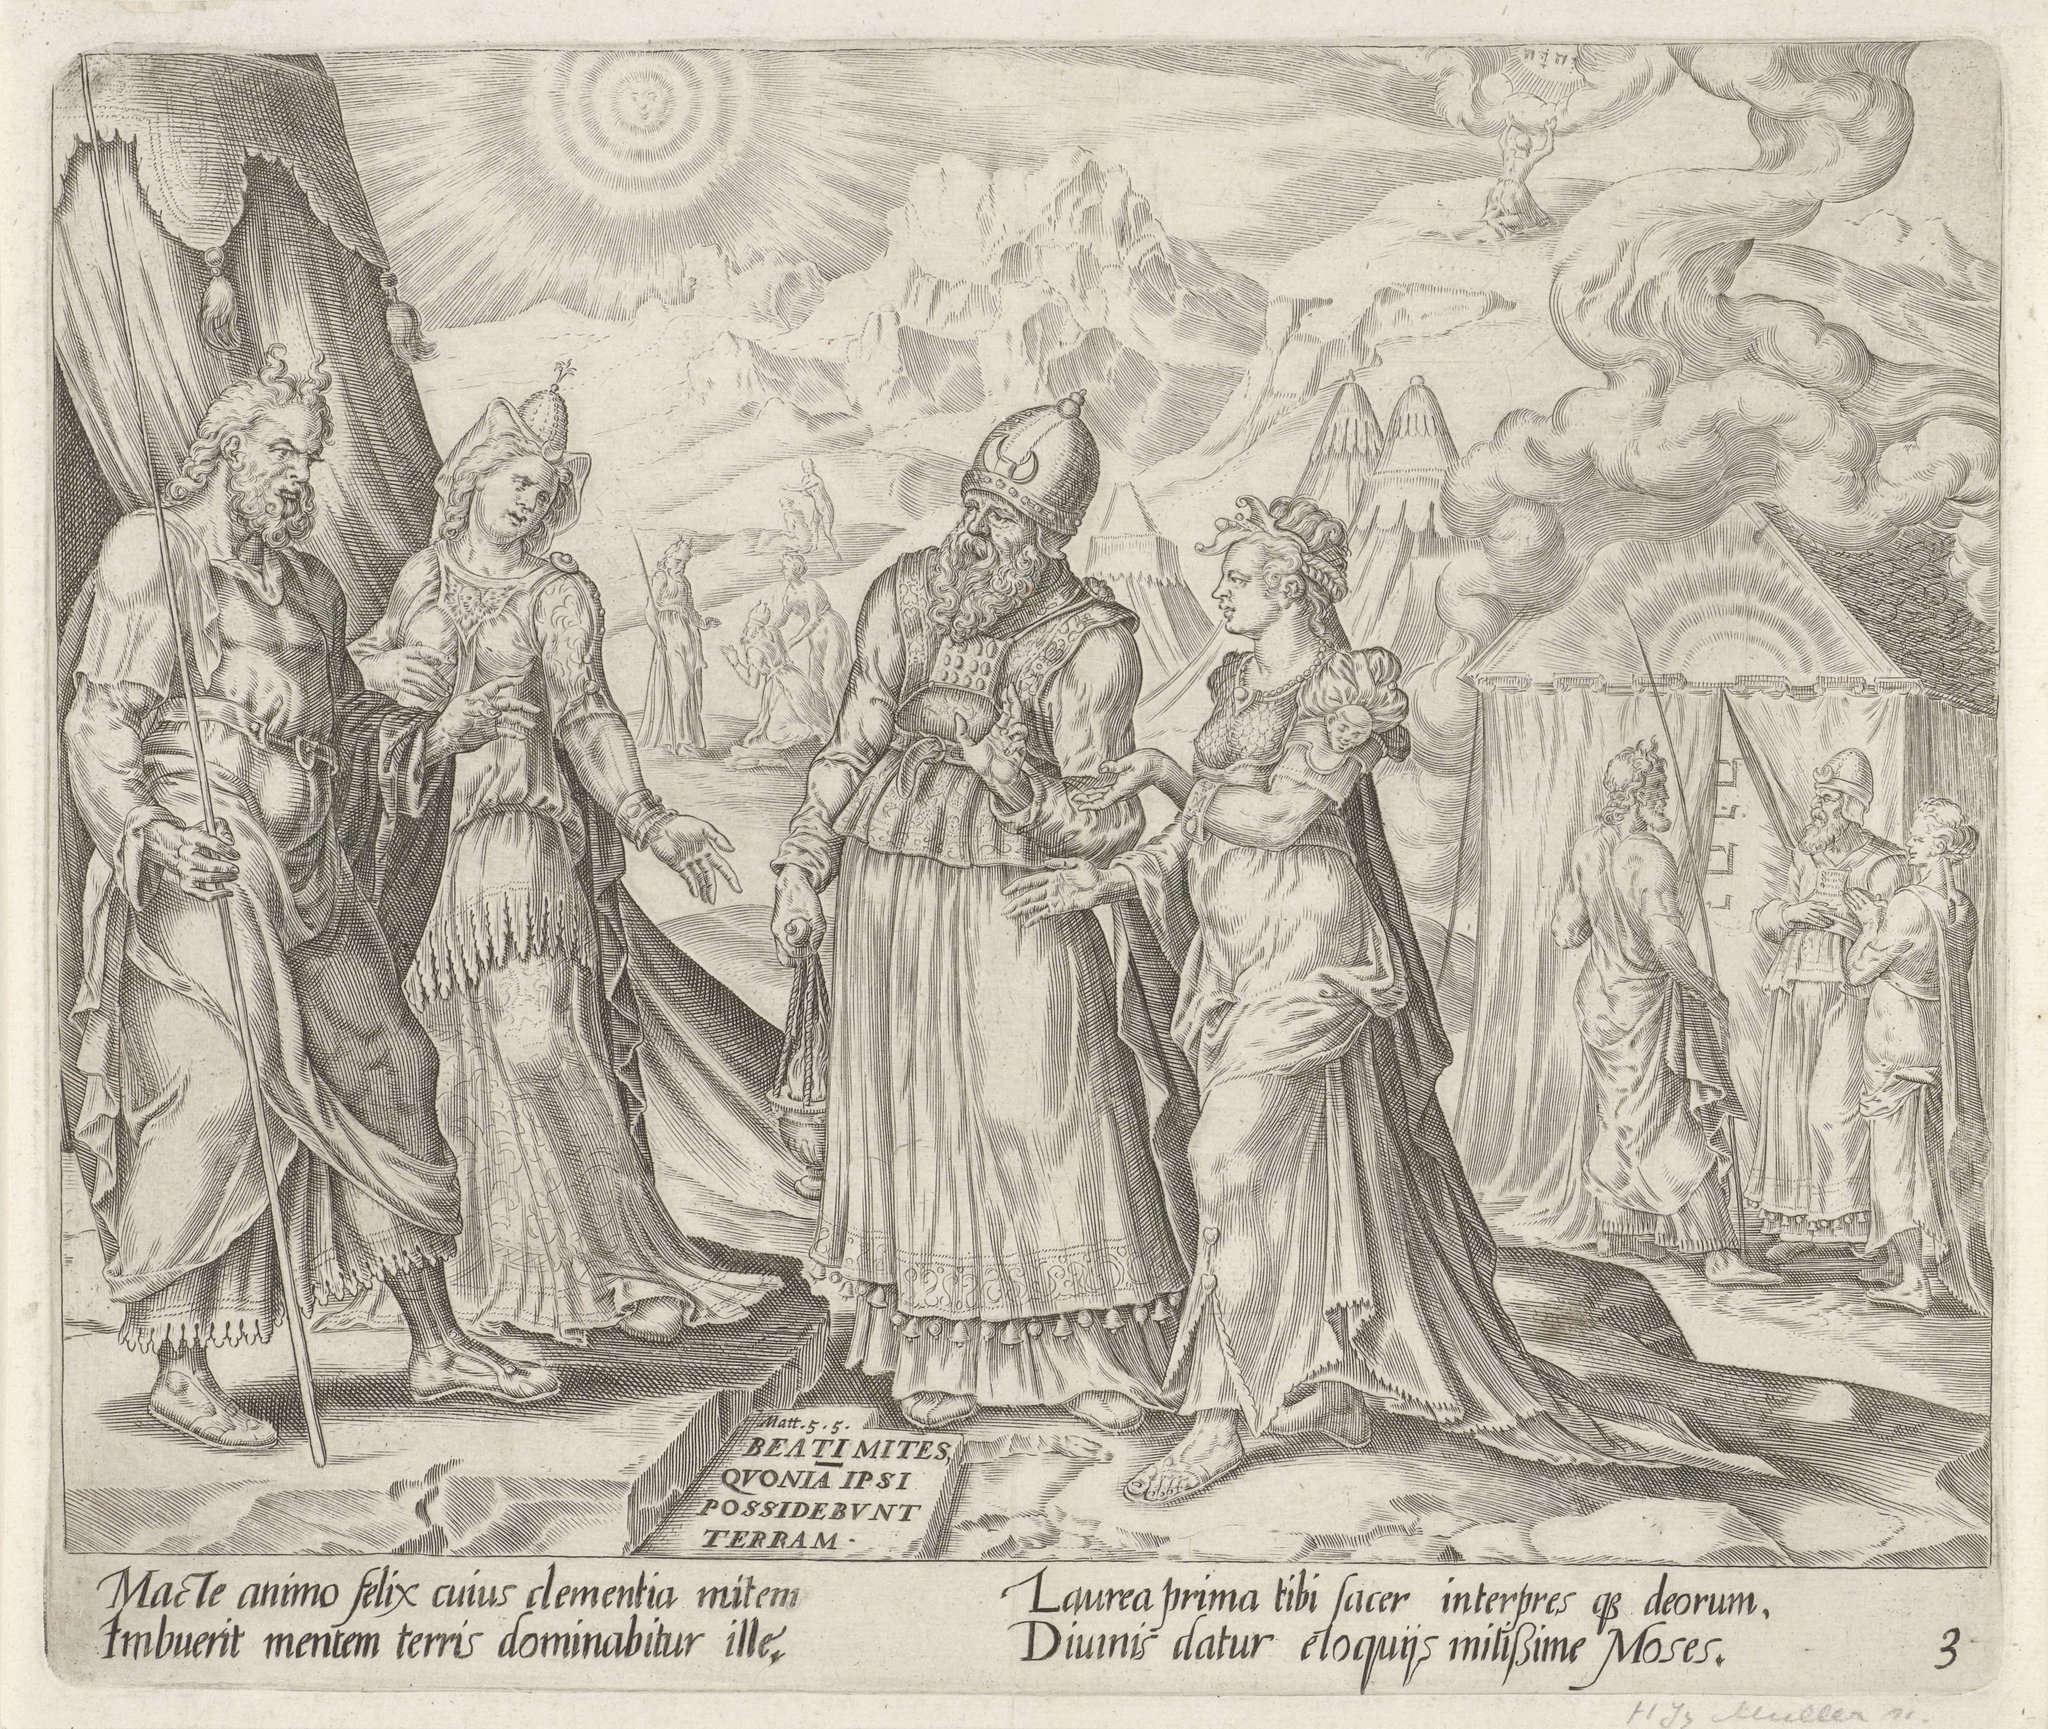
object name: print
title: De acht zaligsprekingen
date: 1564-1568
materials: paper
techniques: engraving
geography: amsterdam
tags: blessed are the meek, sedition of miriam and aaron (numbers 12)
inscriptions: collector's mark: Lugt 2760, collector's mark: Lugt 2228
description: Aäron en Mirjam staan voor Mozes en zijn Nubische vrouw en betwisten zijn gezag door aanmerkingen te maken over zijn huwelijk met haar. Rechts spreken Mozes, Aäron en Mirjam met God, die in de vorm van het tetragram in de deuropening van de verbondstent verschijnt. In het landschap smeekt Aäron op zijn knieën Mozes om zijn zonde niet aan te rekenen. Mirjam zit getroffen door huidvraat in de woestijn. Op de berg bidt Mozes om genezing voor haar. Prent maakt deel uit van een serie over de acht zaligsprekingen van Christus en illustreert de zaligspreking: Zalig zijn de zachtmoedigen. Op de trap een steen met deze tekst uit Mat. 5:5 in het Latijn. Onderaan in de marge een vers in het Latijn over de zaligspreking en de voorstelling.